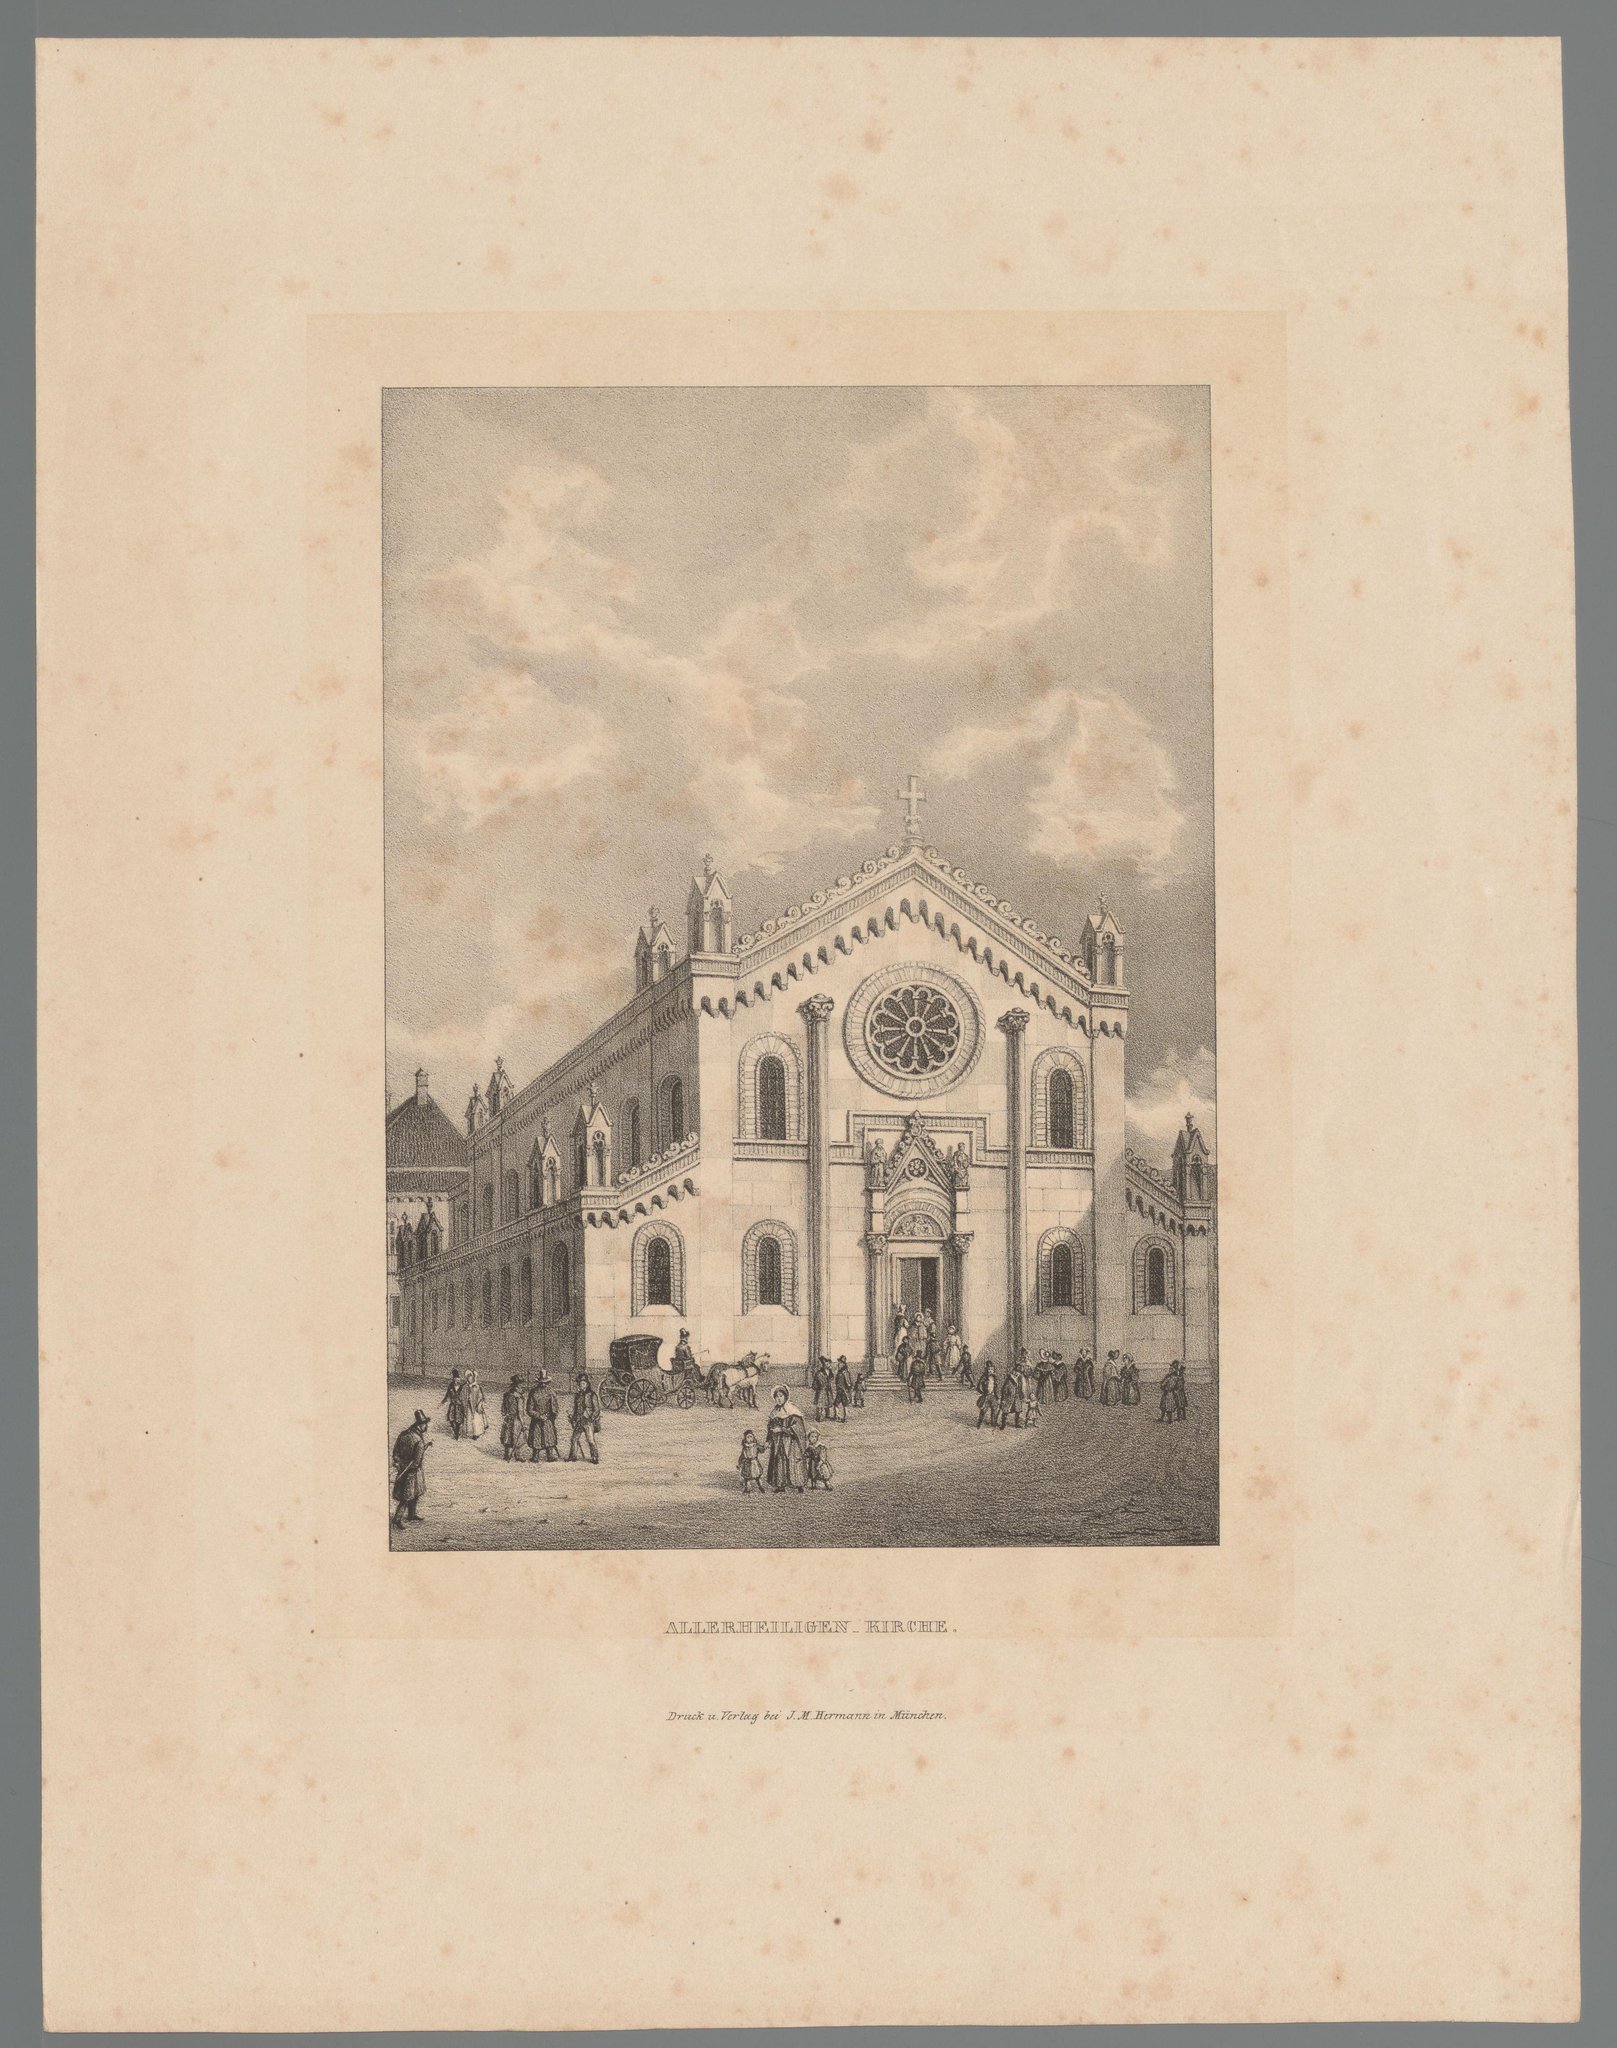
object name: print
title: Stadsgezichten in München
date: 1797-1862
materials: paper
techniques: lithograph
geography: munich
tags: city-view in general; 'veduta', church (exterior)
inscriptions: collector's mark: Lugt 2228